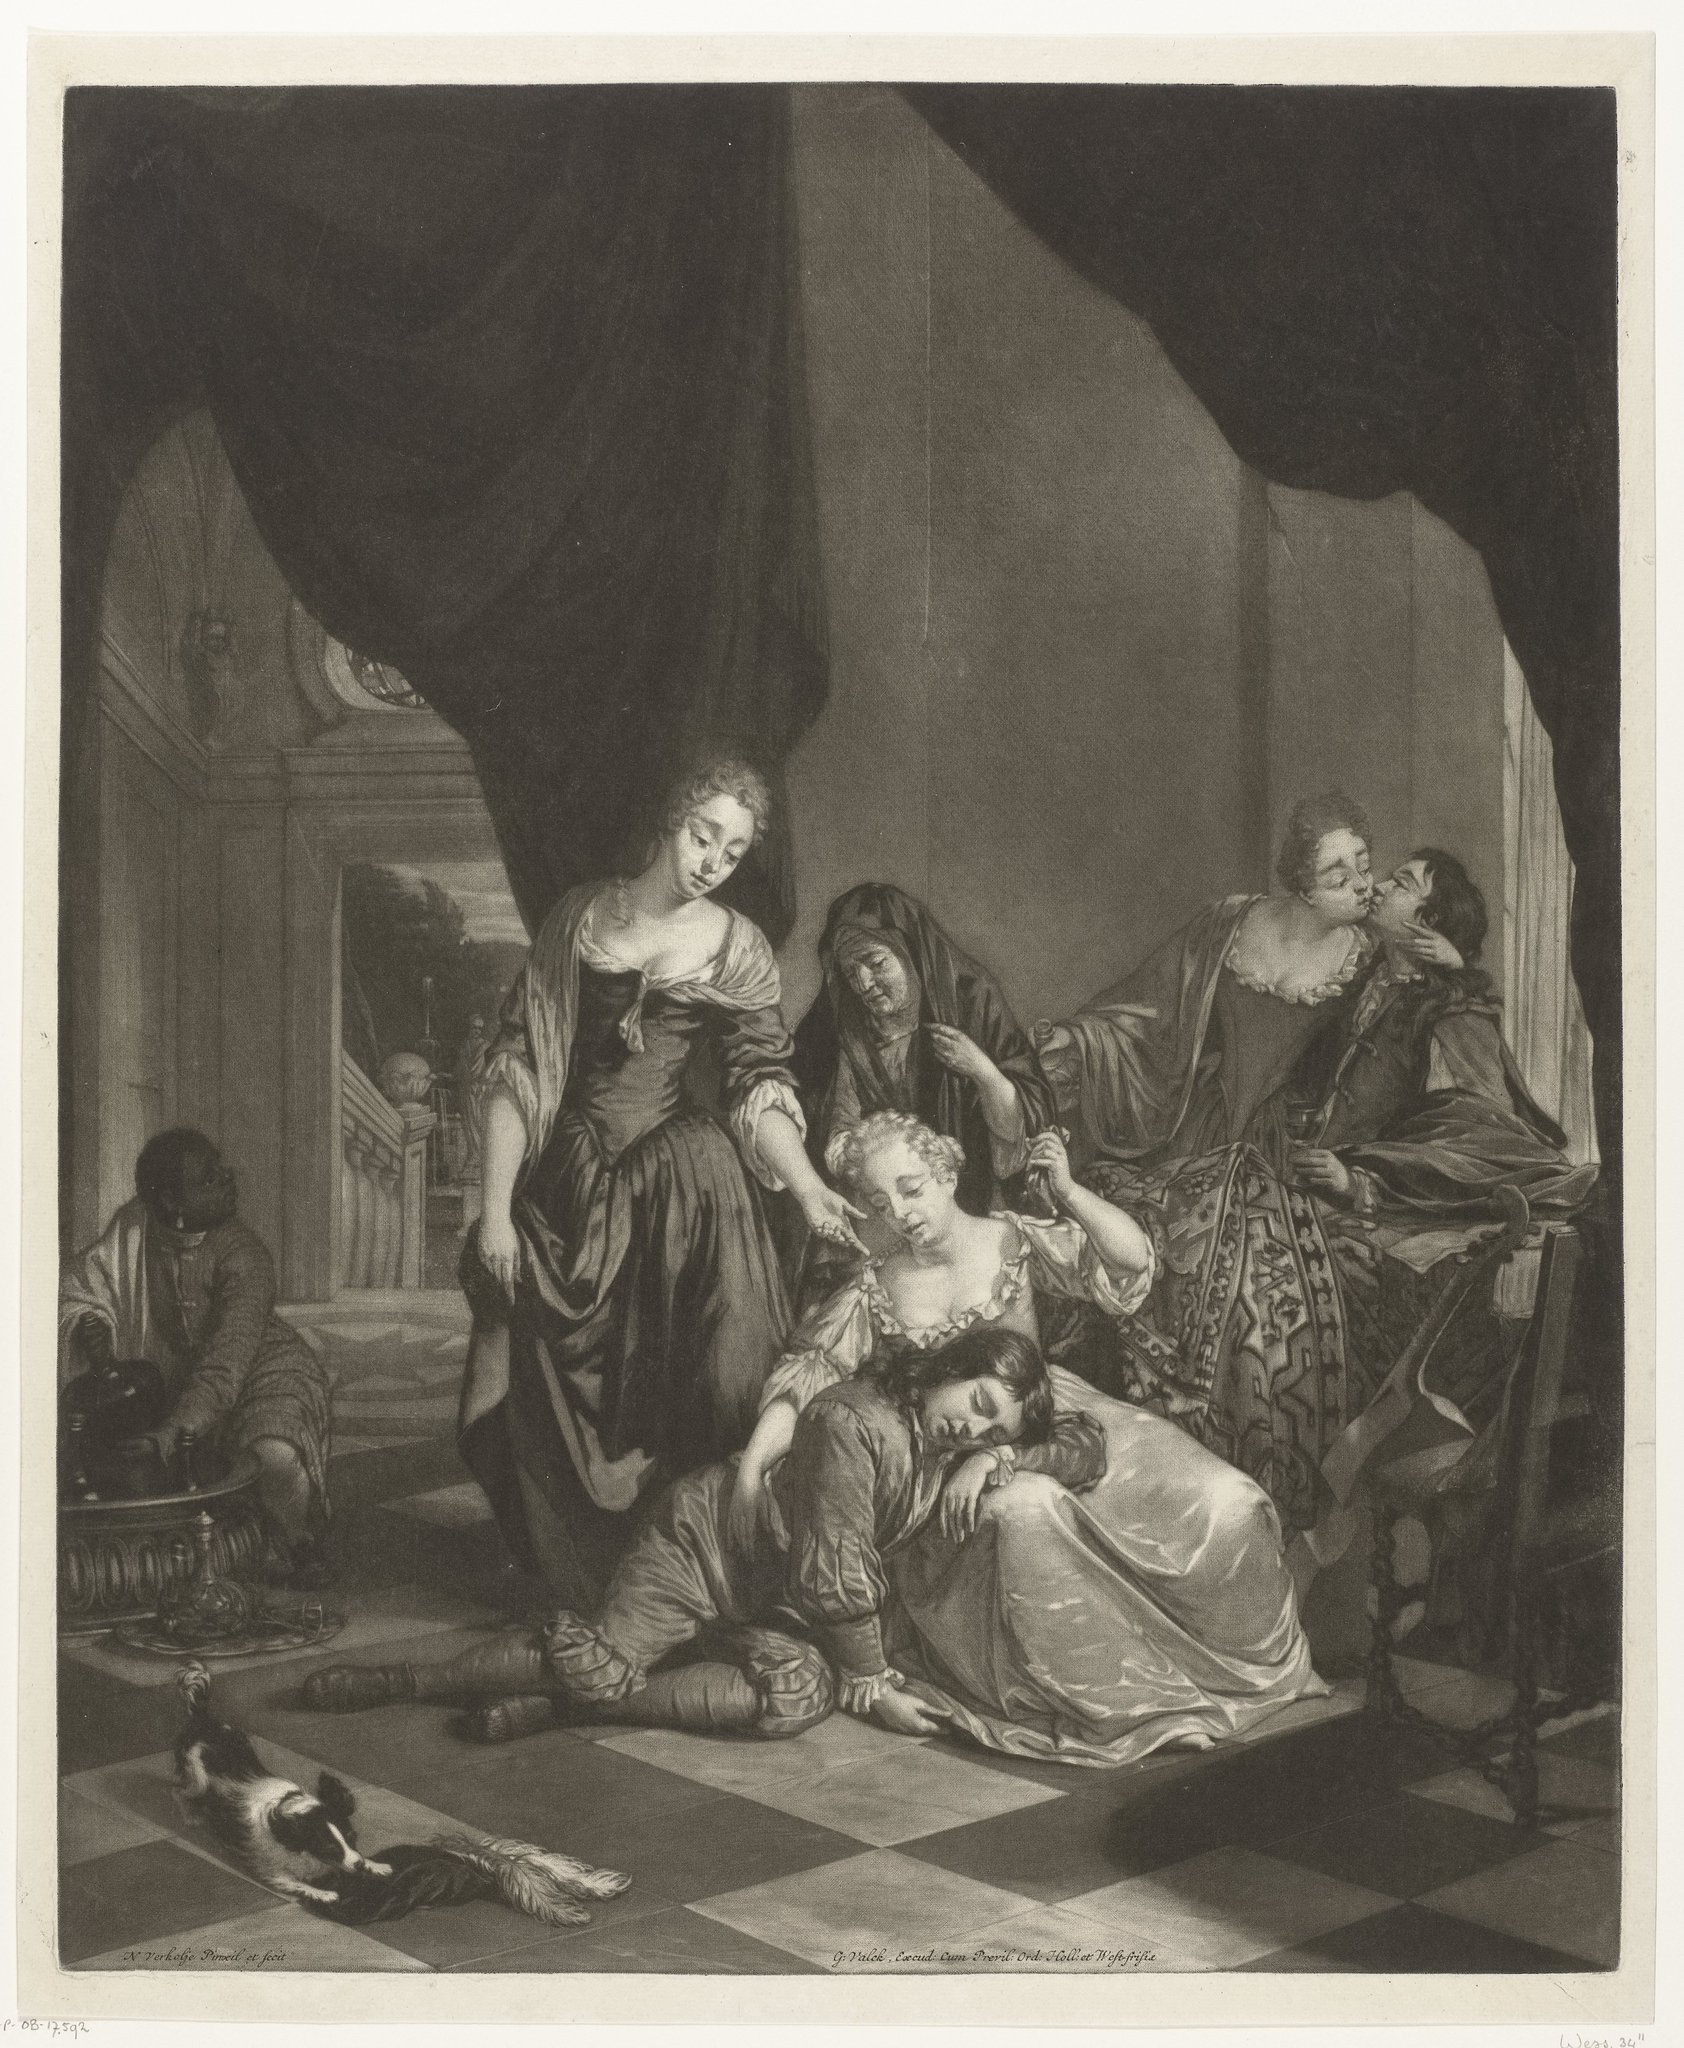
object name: print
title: Bordeelscène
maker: gerard valck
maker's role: print maker, publisher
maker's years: 1651-1726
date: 1683-1726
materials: paper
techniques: mezzotint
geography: amsterdam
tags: brothel, theft, the prodigal son in the midst of prostitutes feasting and dissipating his patrimony, usually in a brothel or inn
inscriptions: collector's mark: Lugt 240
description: In een bordeel is een jongeman op de schoot van een vrouw van lichte zeden in slaap gevallen, zij besteelt hem. Achter hen wordt een tweede man bedwelmd met zoenen en wijn.